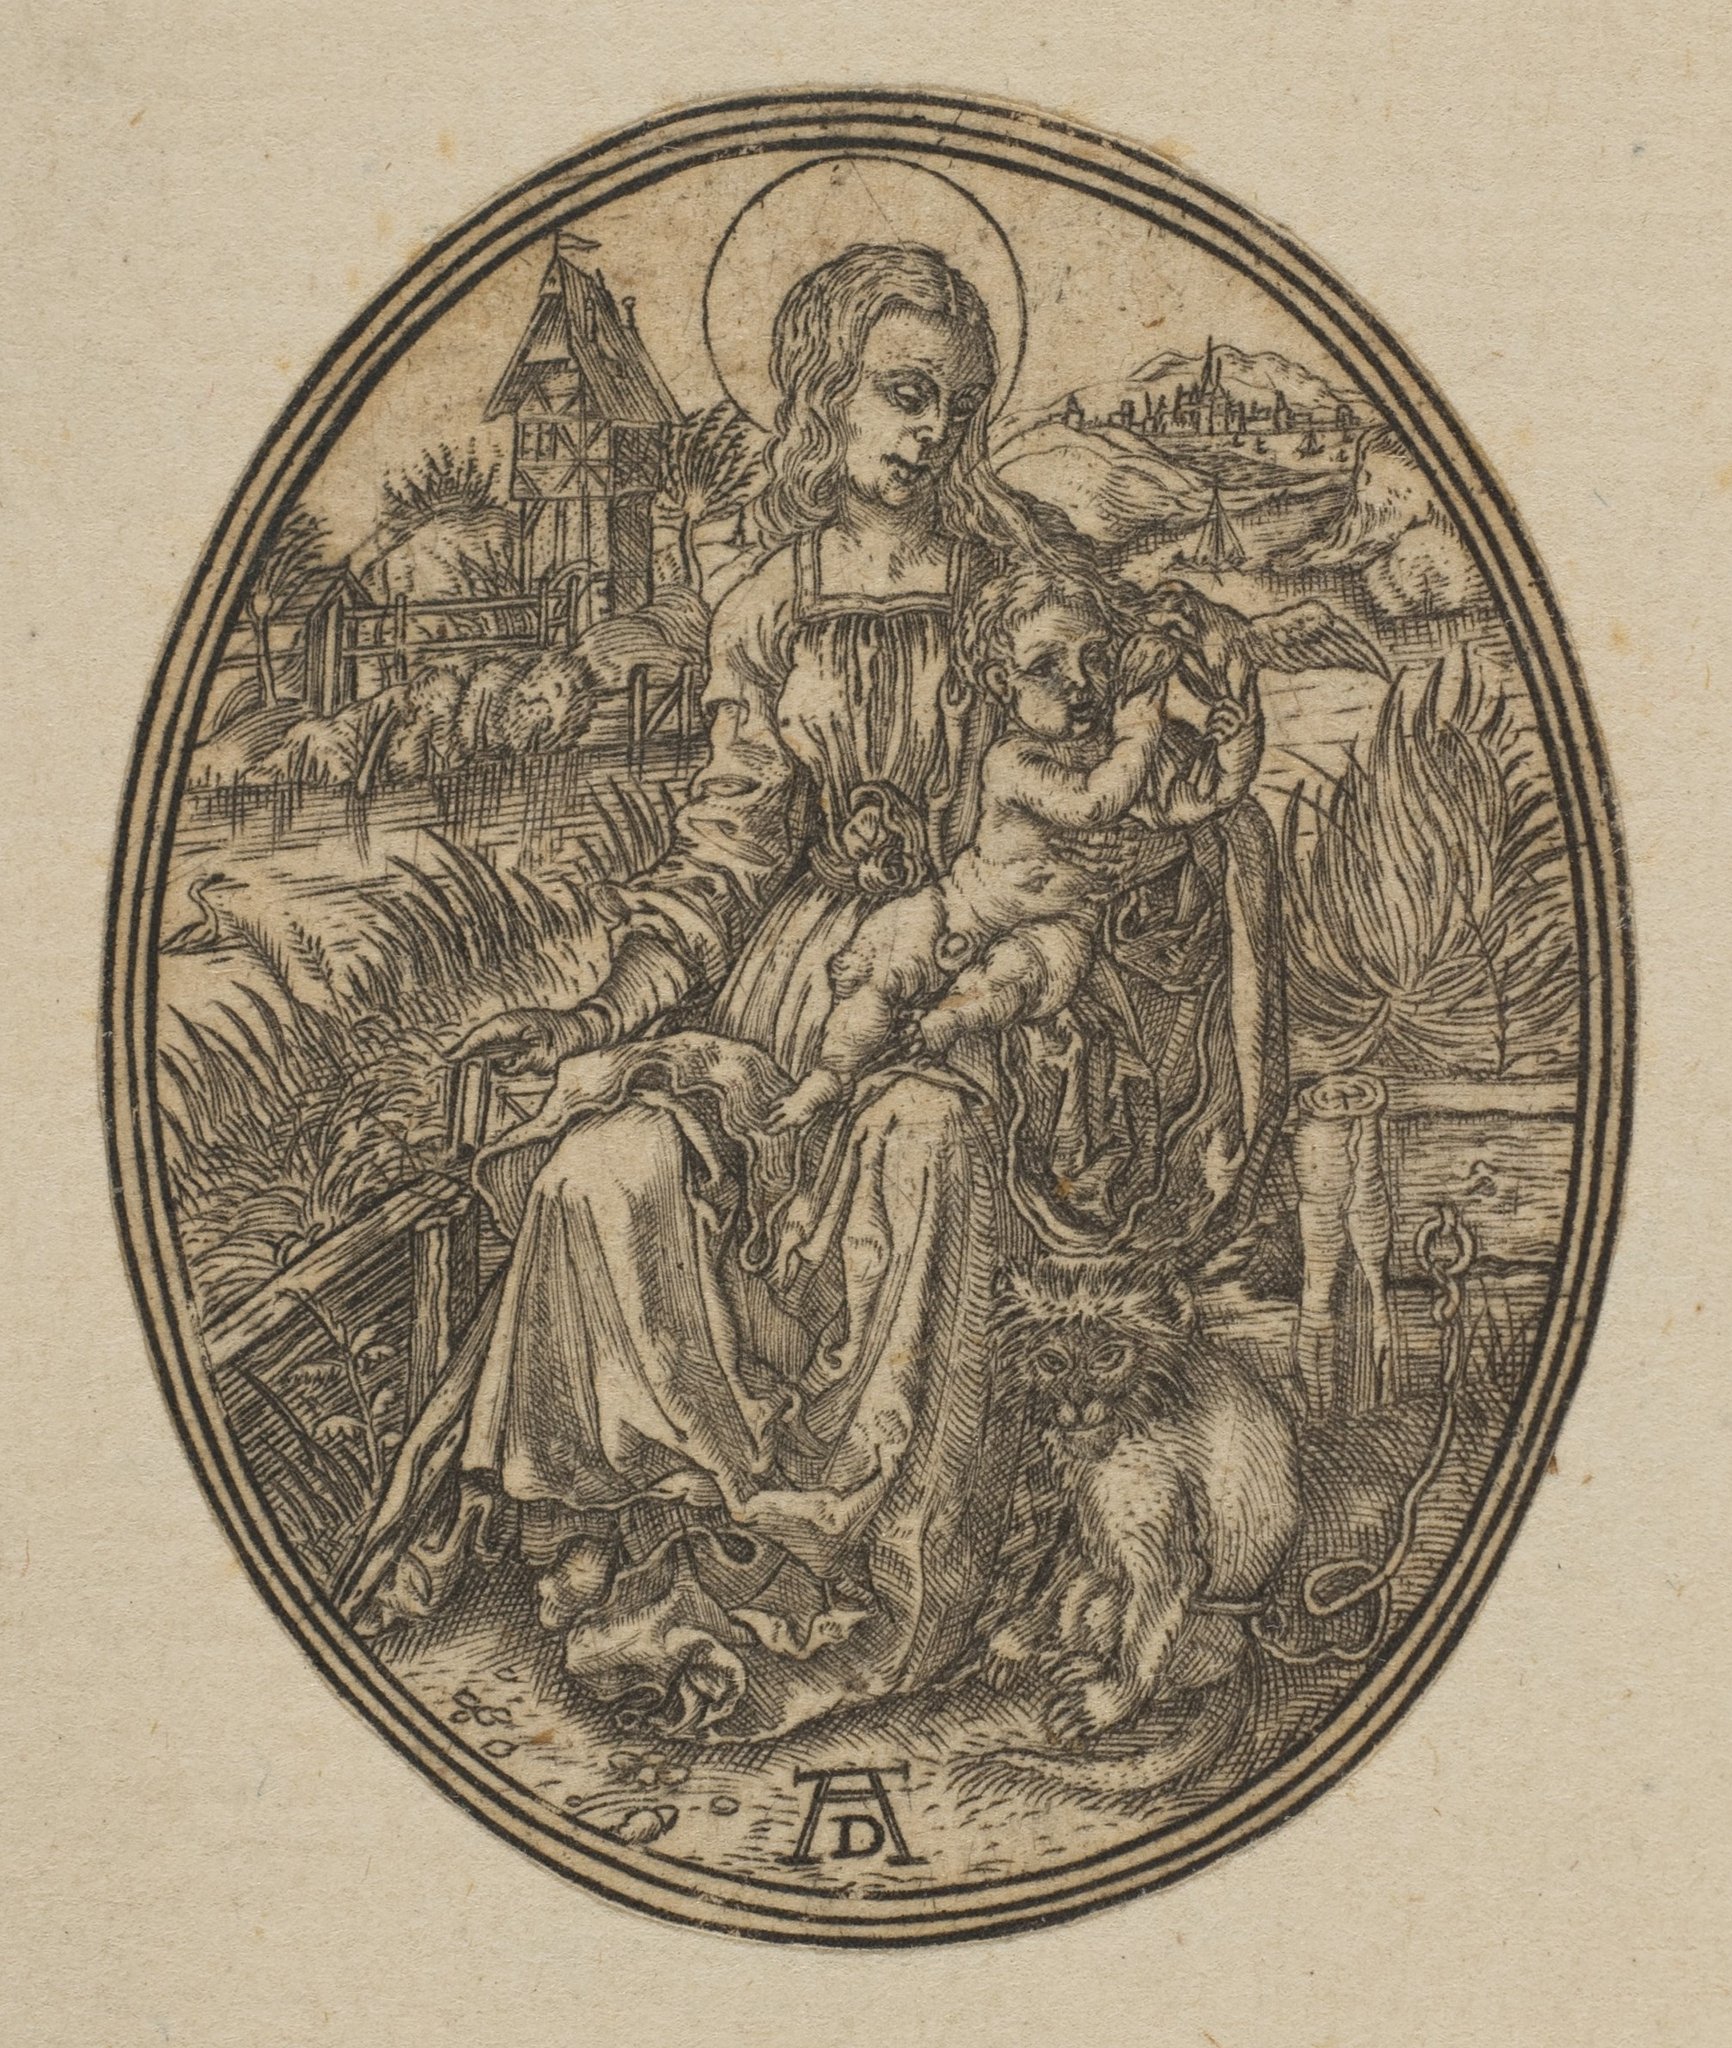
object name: print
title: Virgin and Child with the Monkey (reverse copy)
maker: albrecht dürer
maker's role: artist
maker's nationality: german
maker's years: 1471-1528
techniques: engraving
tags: birds,monkeys,madonna and child